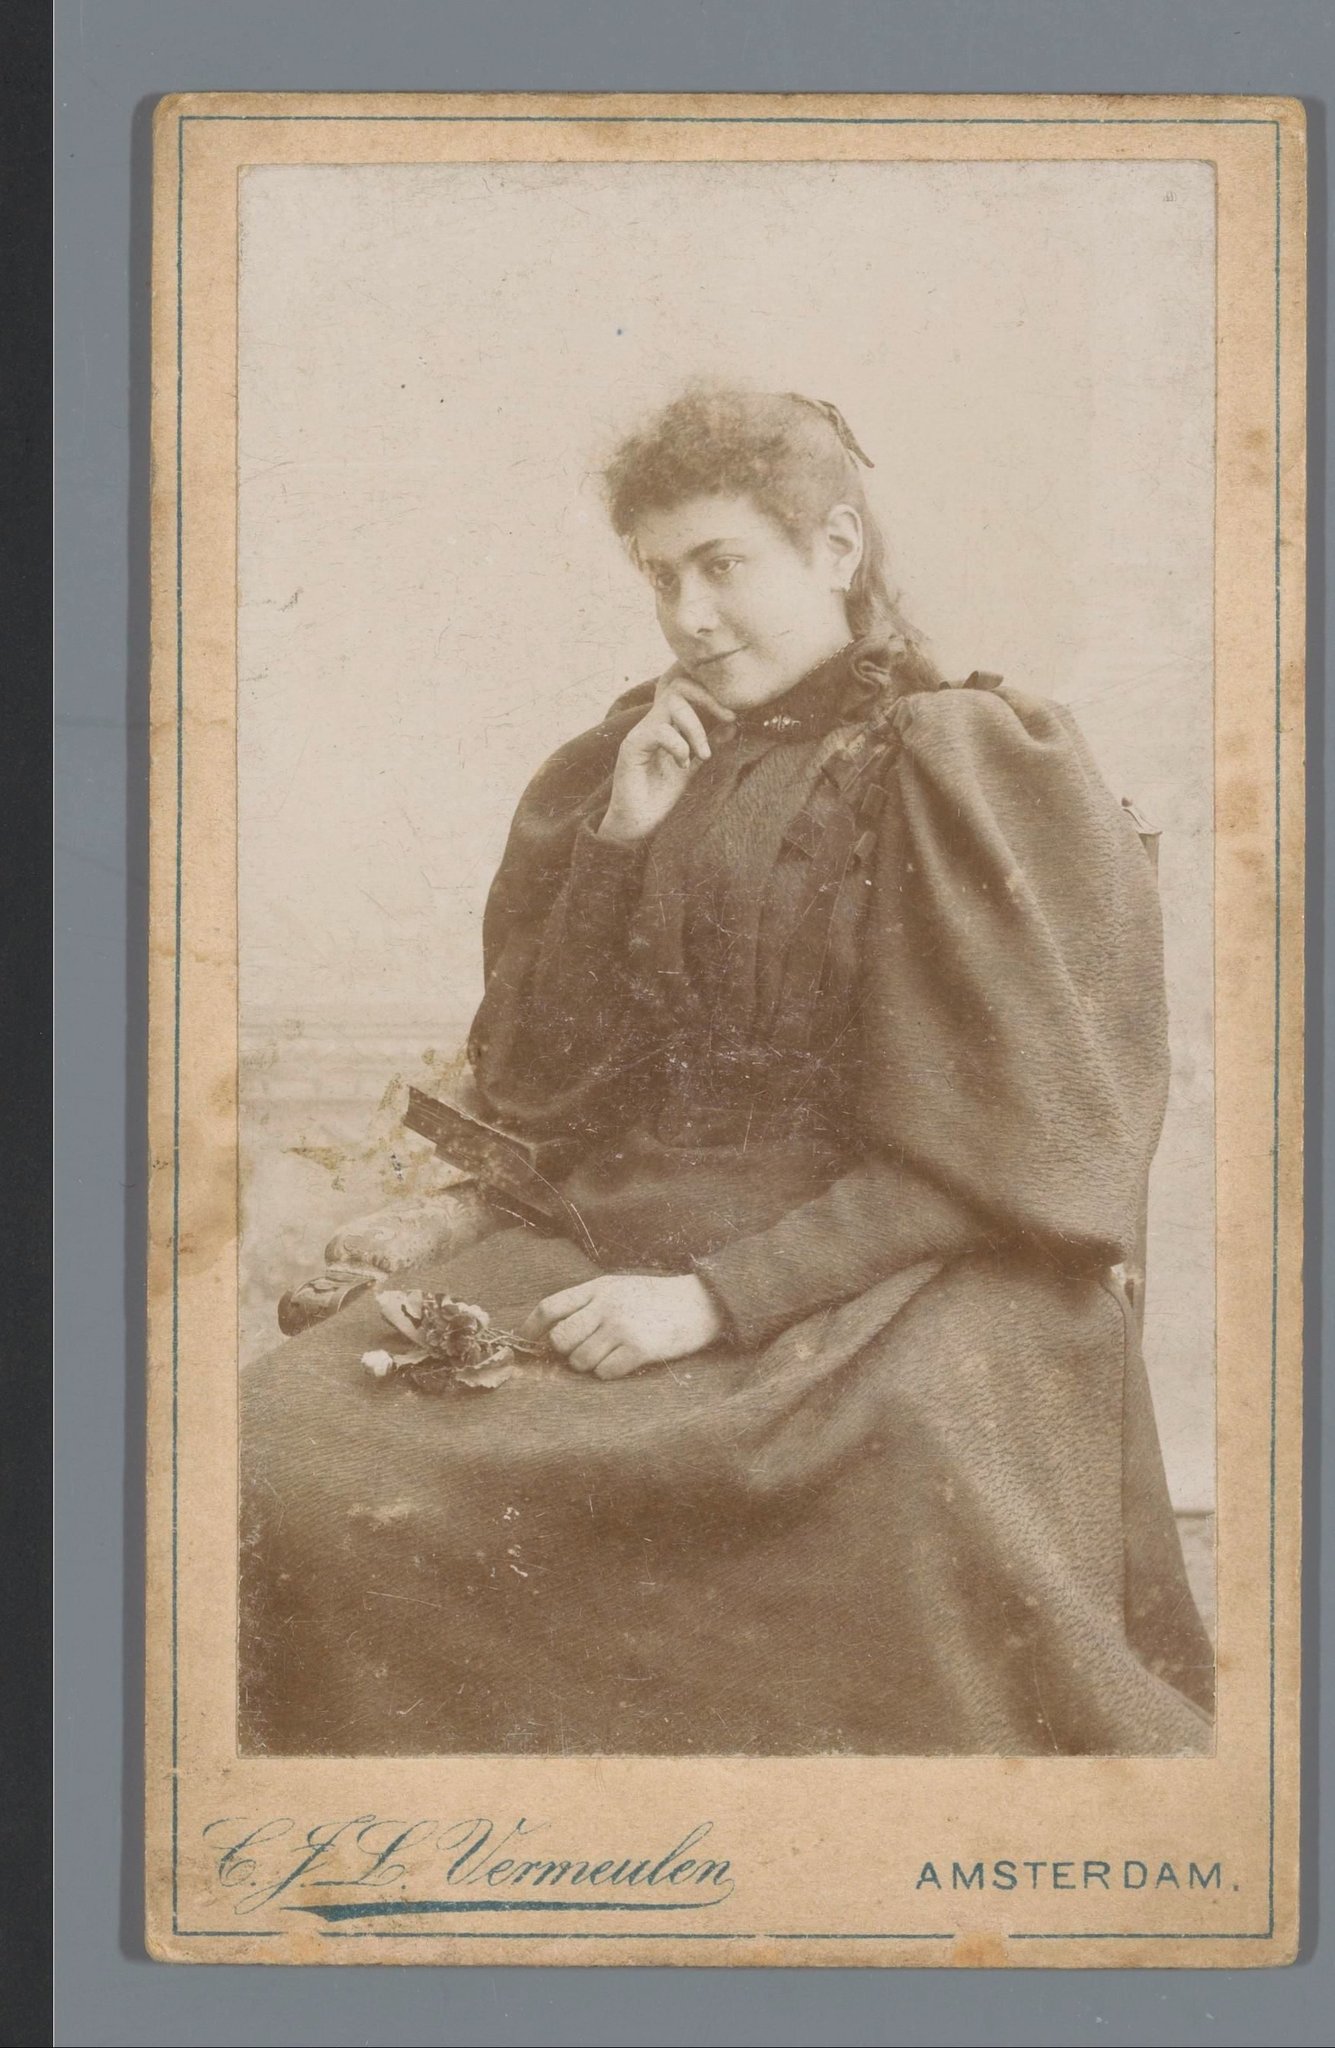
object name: photograph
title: Portret van een onbekende vrouw met een roos op haar schoot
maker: cornelis johannes lodewicus vermeulen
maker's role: fotograaf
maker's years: 1861-1936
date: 1888-1896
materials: cardboard, photographic support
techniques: collodion silver print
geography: amsterdam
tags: sitting figure, historical persons - bb - woman, flowers: rose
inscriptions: inscription: ‘C. J. L. VERMEULEN/ Amsterdam/ Heerenstraat 6,/ Heiligenweg hoek Singel./ Specialiteit in vergrootingen’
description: De geportretteerde vrouw is ook afgebeeld op RP-F-F21933.